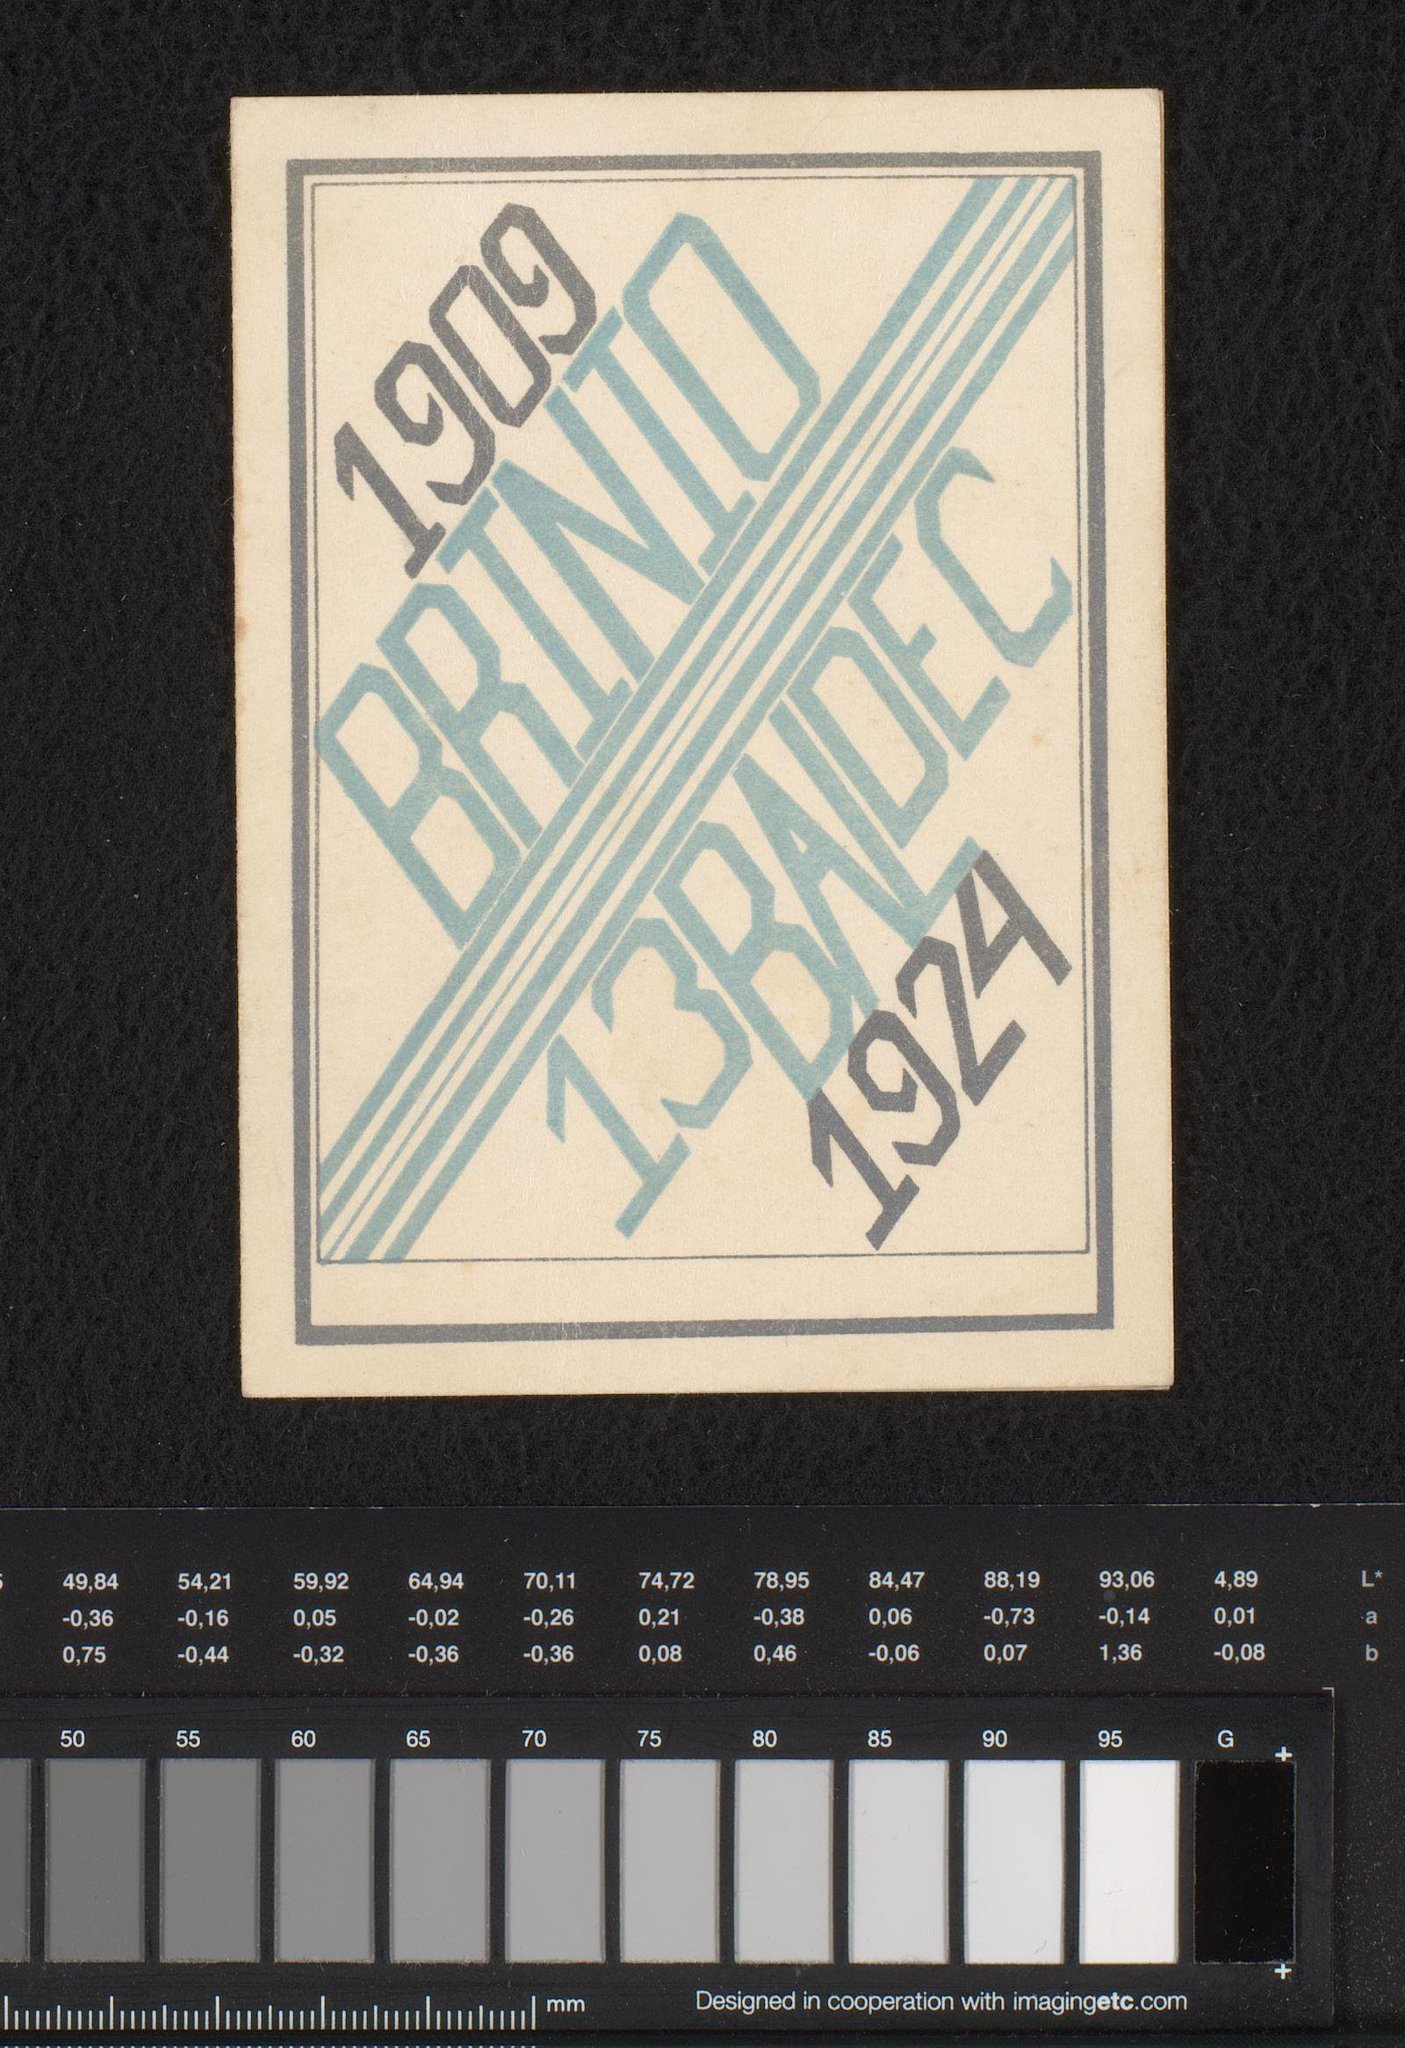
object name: photomechanical print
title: Balboekje voor het Brinio-bal op 13 december 1924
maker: Anonymous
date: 1924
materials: paper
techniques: letterpress printing, printing block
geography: groningen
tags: ball, formal dance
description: Op de voorzijde: '1901 Brinio bal 13 dec 1924'. Binnenin de lijst van twaalf dansen met daarachter diverse namen in handschrift. Op de achterzijde een dansend paar.